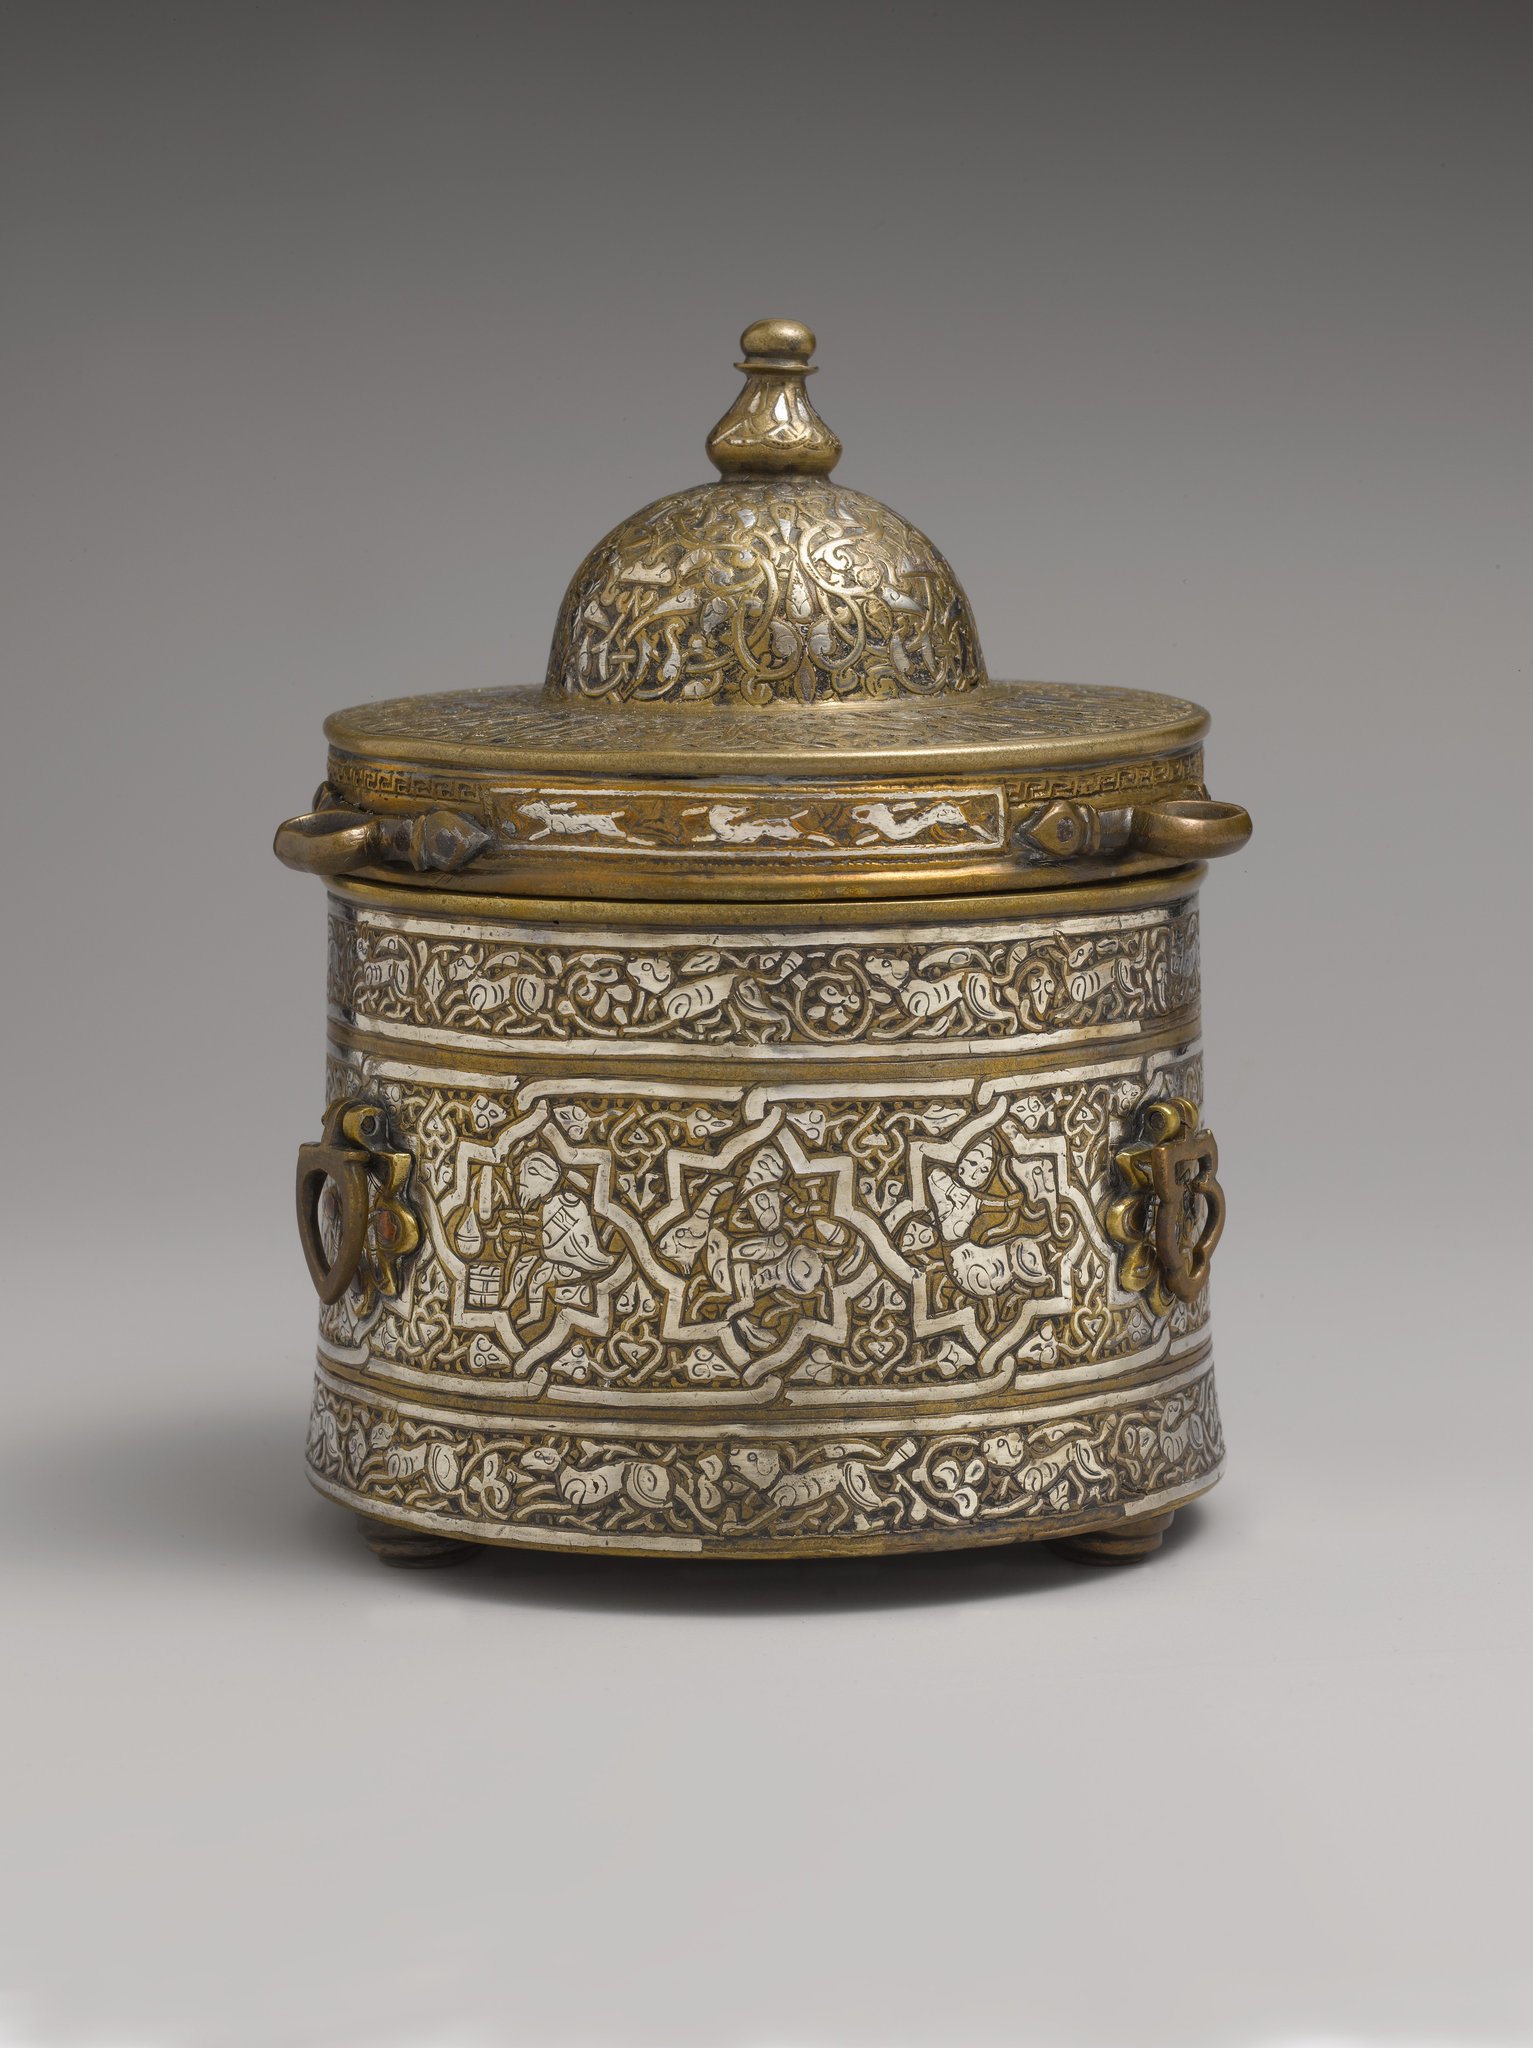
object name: inkwell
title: Inkwell with Zodiac Signs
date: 1201-1233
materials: brass, copper, silver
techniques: casting, inlay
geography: iran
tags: zodiac